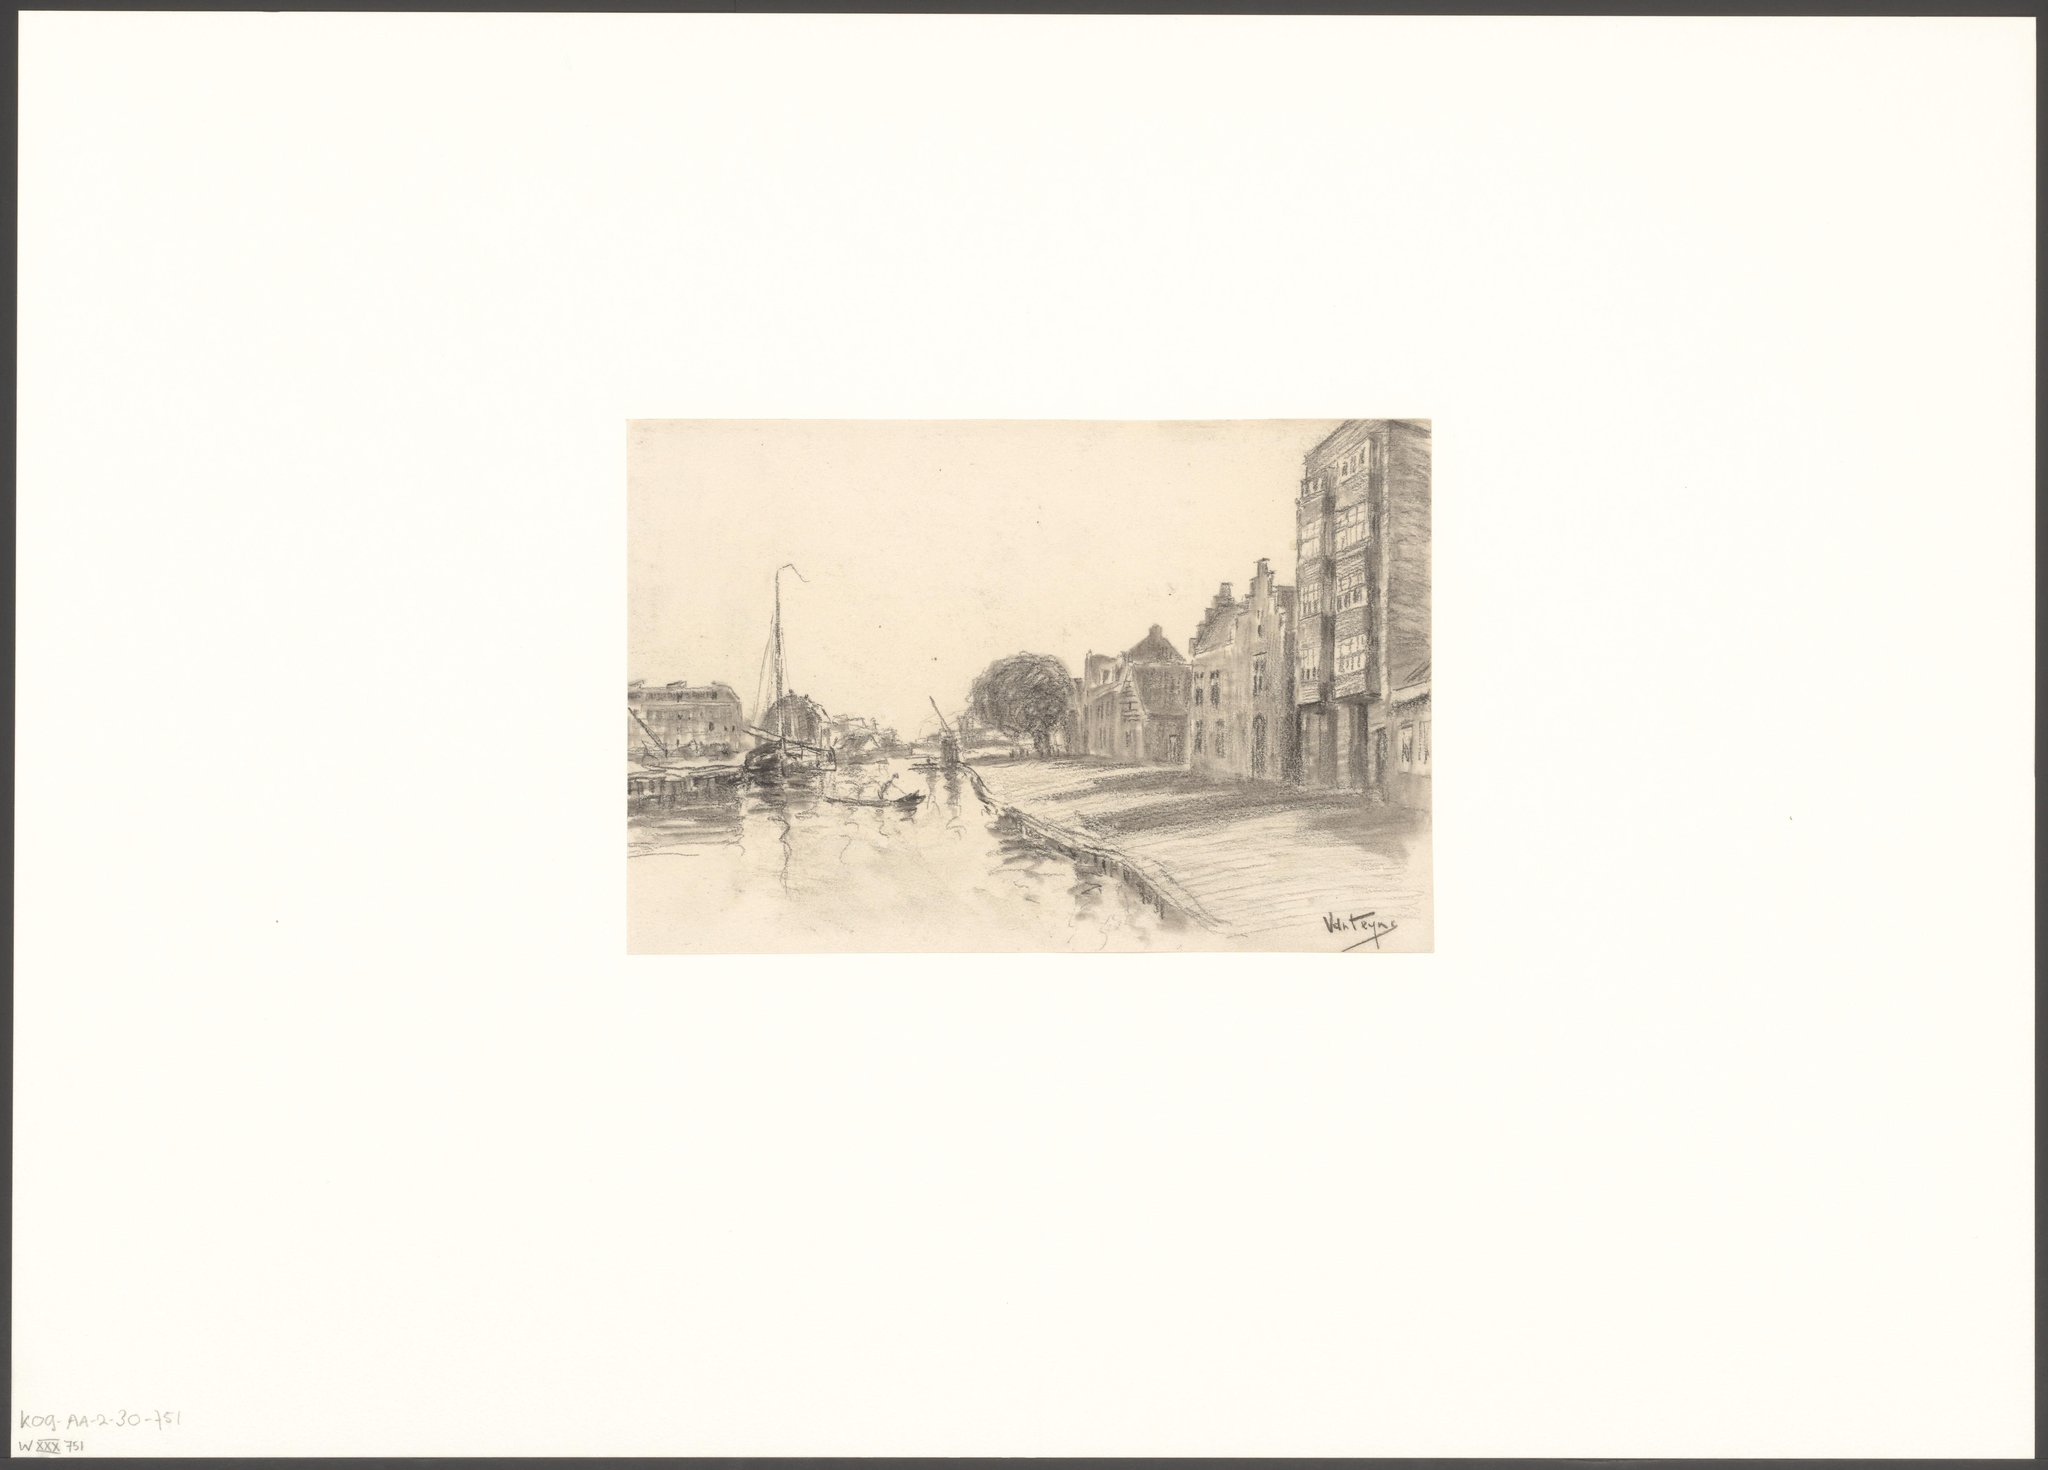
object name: drawing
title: Gezicht op de Baarsjesweg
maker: anthonie van teijn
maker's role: draughtsman, painter, print maker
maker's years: 1863-1943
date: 1907-1927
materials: chalk, paper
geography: amsterdam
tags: city-view in general; 'veduta', canal, street, boat propelled by man or animal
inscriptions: signature: ‘VanTeyne’, collector's mark: Lugt 800a, inscription: ‘De Baarsjes weg (...) Juli 1927 / vanEck’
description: Tekening binnen de Atlas Van Eck ingedeeld op wijknummer 30.